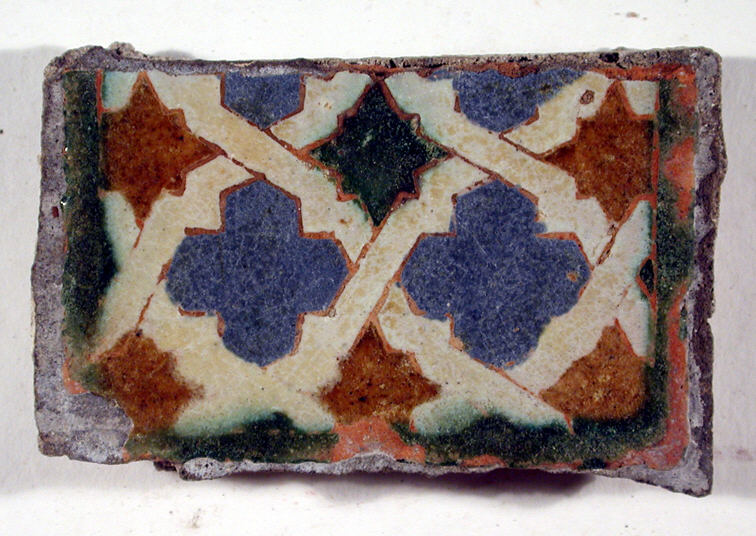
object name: pavement tile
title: Pavement tiles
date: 1501-1600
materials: earthenware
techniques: glazing